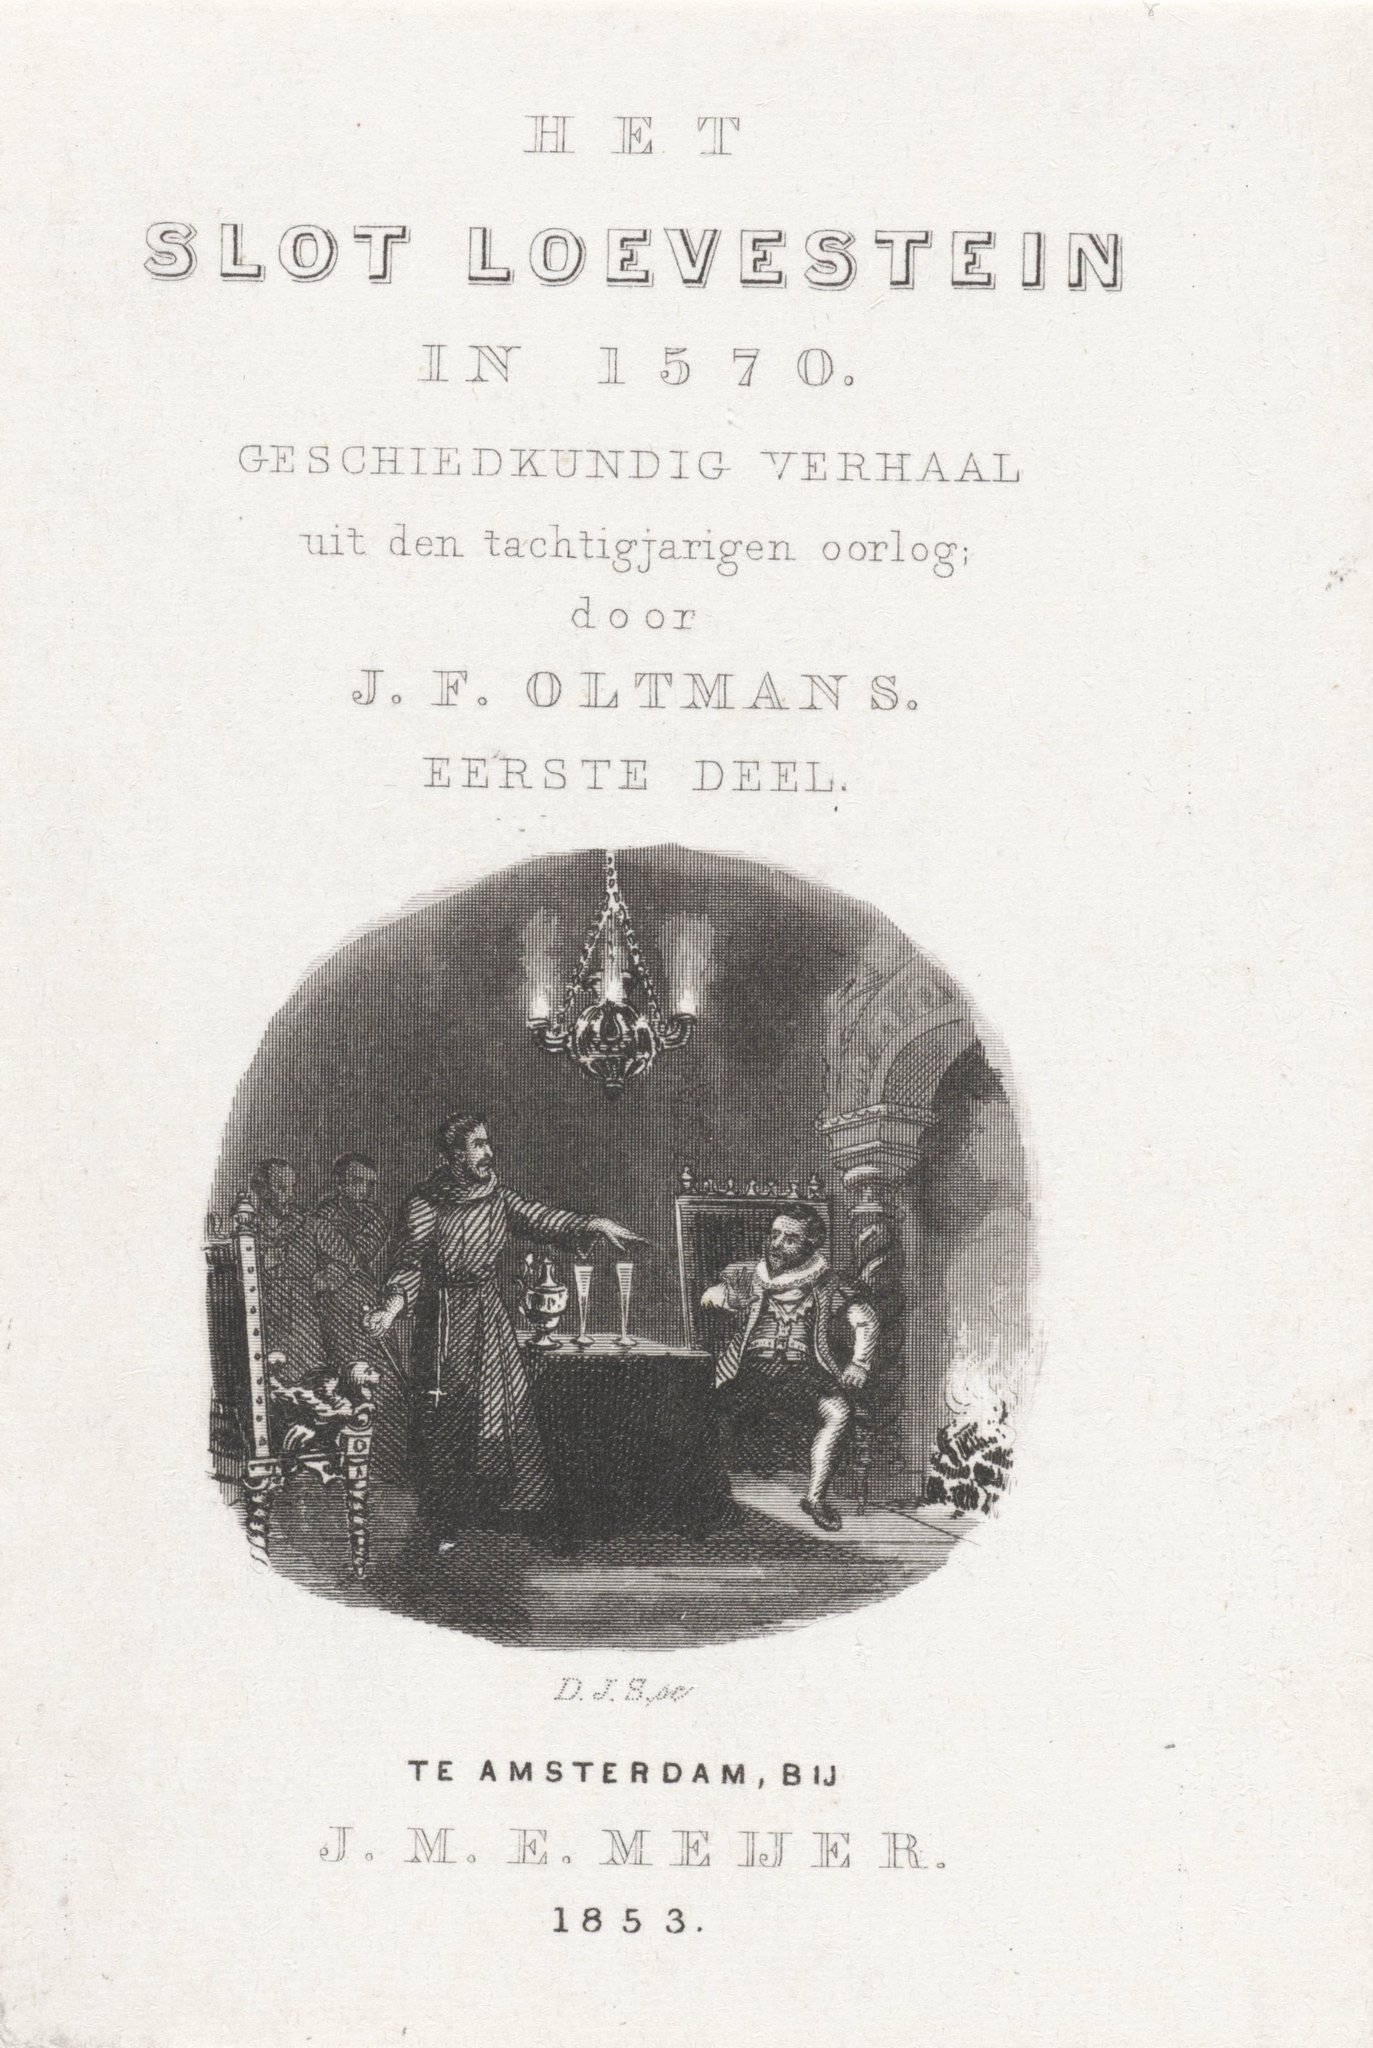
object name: print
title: Titelpagina voor: J.F. Oltmans, Het slot Loevestein in 1570, eerste deel, 1853.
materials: paper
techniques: engraving, etching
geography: amsterdam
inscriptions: collector's mark: Lugt 2228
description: Een kasteelheer zit in een stoel bij een brandende haard. Op de tafel naast hem staat een karaf met twee glazen. De kasteelheer maakt een afwerend gebaar naar de monnik tegenover hem, die naar hem wijst. Boven de afbeelding de titel en auteur, eronder het impressum.